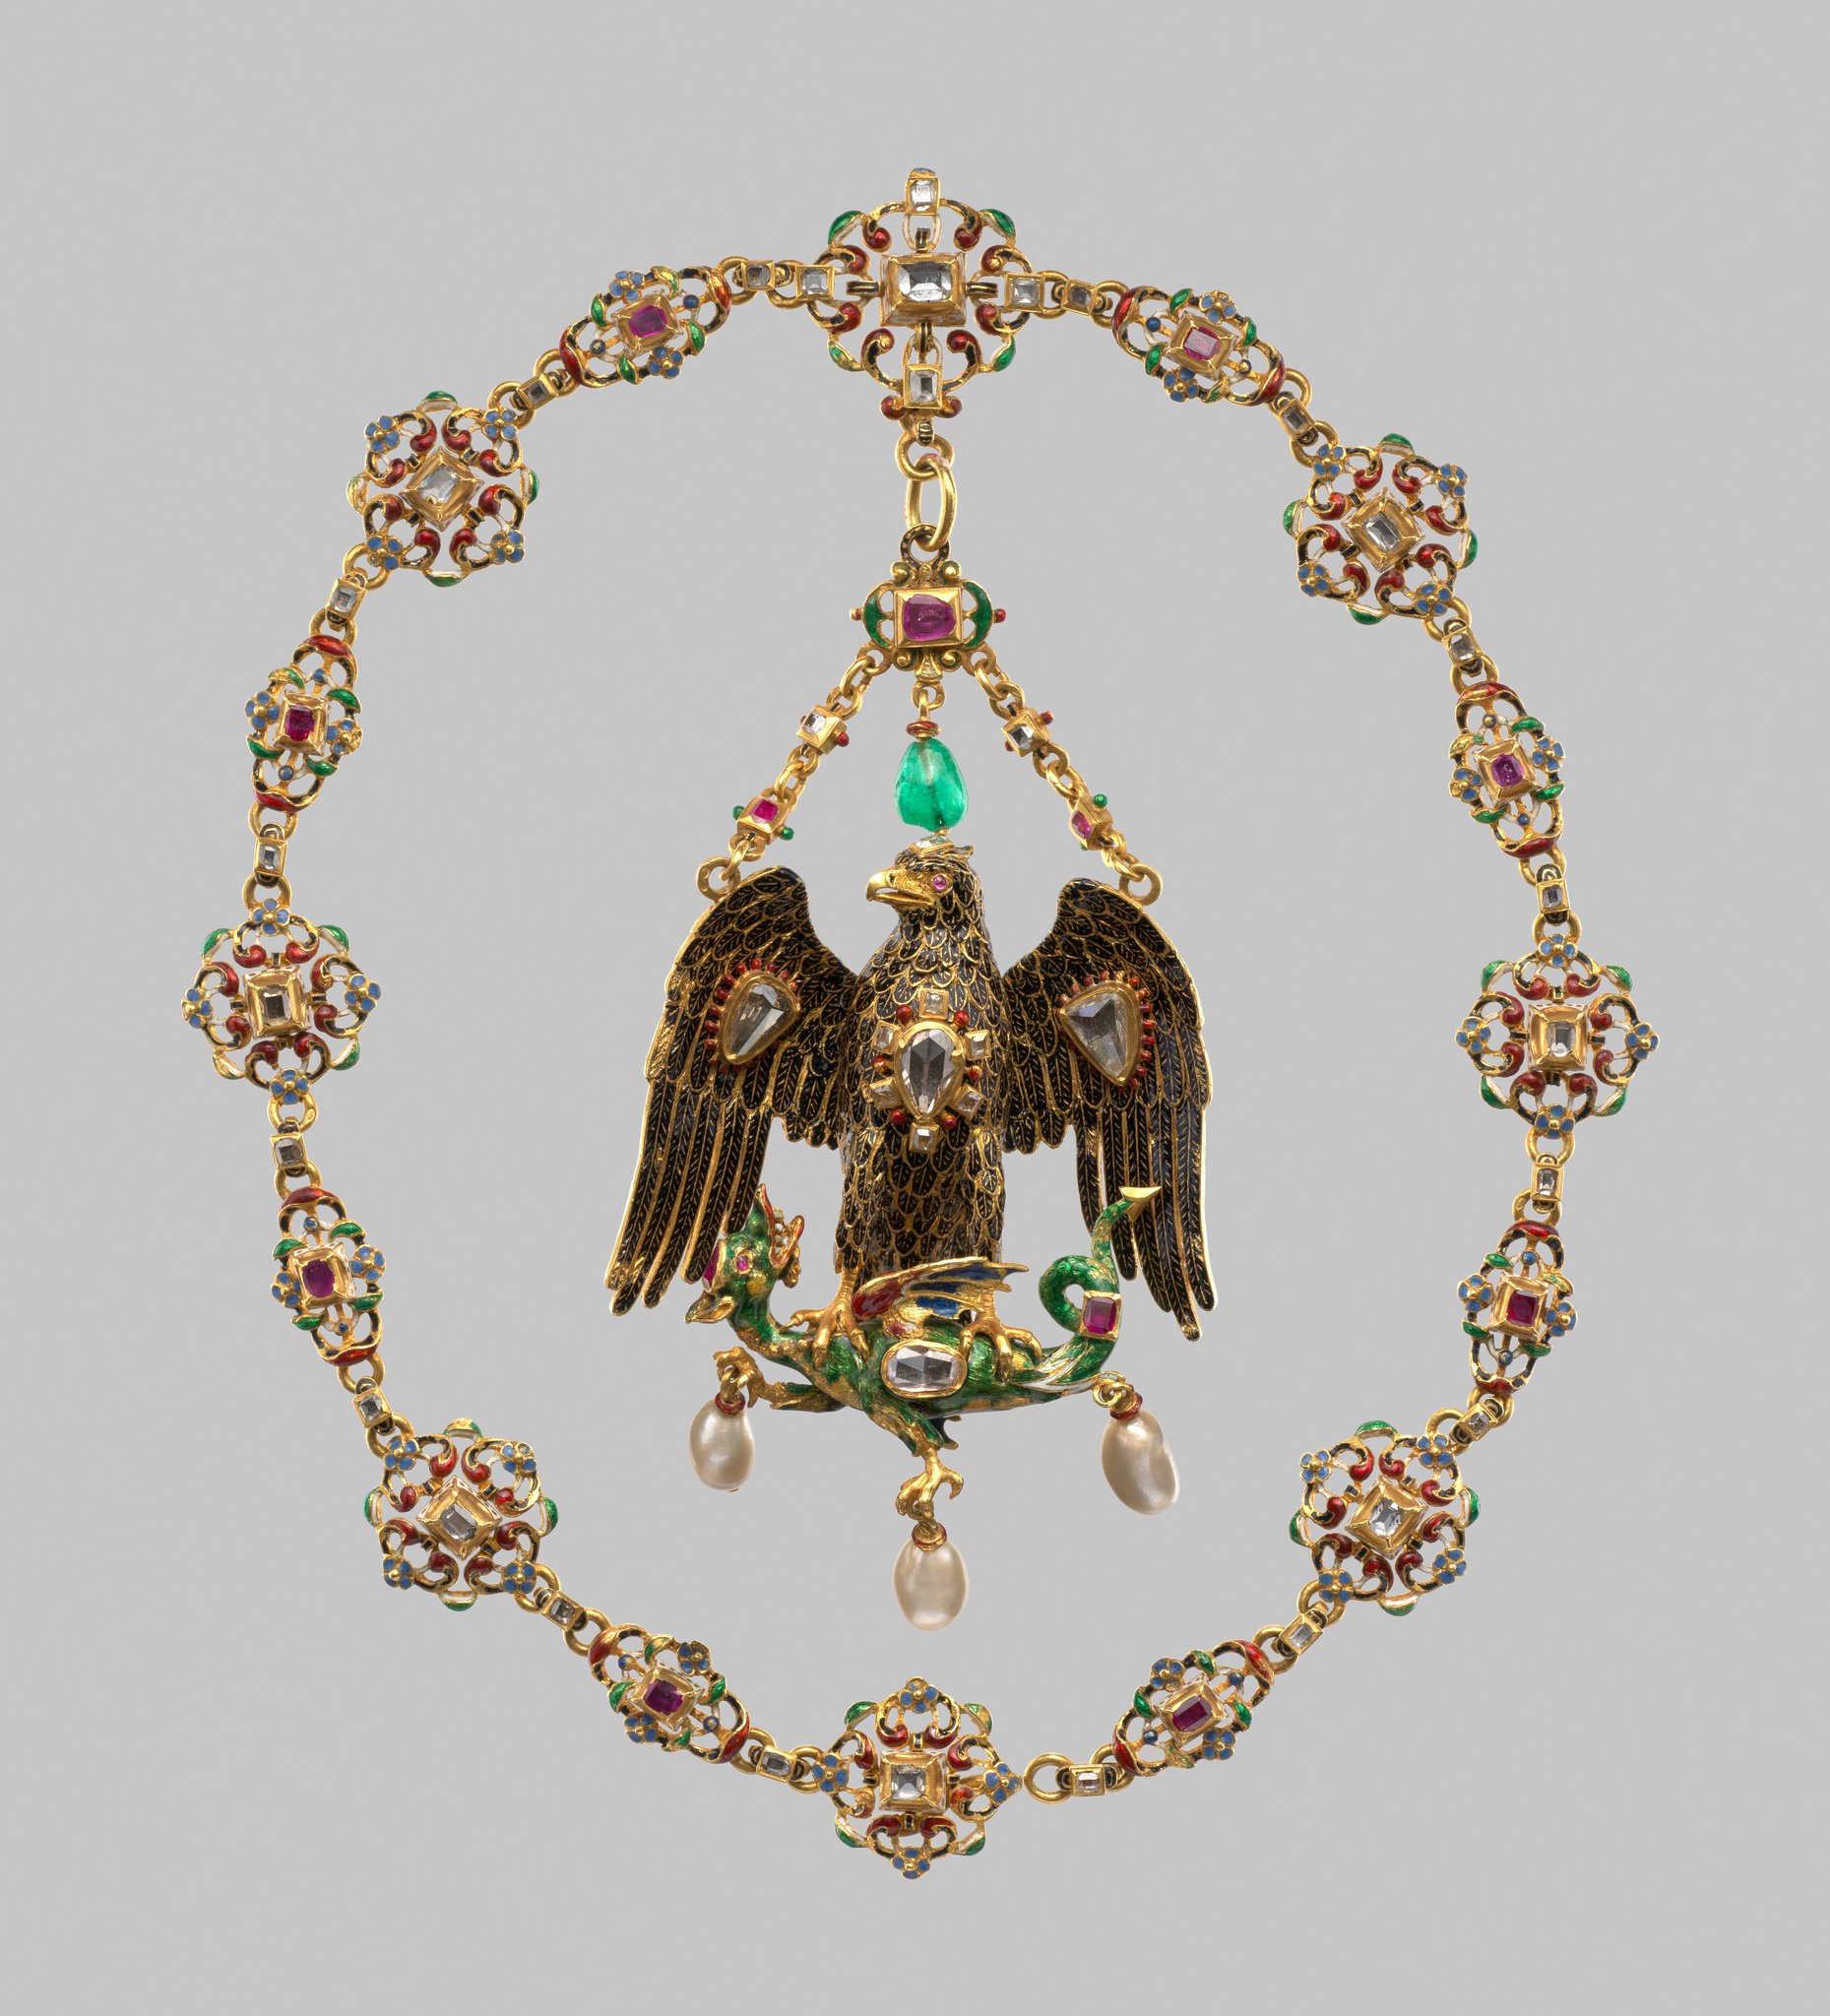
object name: pendant jewelry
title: Pendant and necklace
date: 1876-1900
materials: diamond, gemstone, enamel, gold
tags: eagles